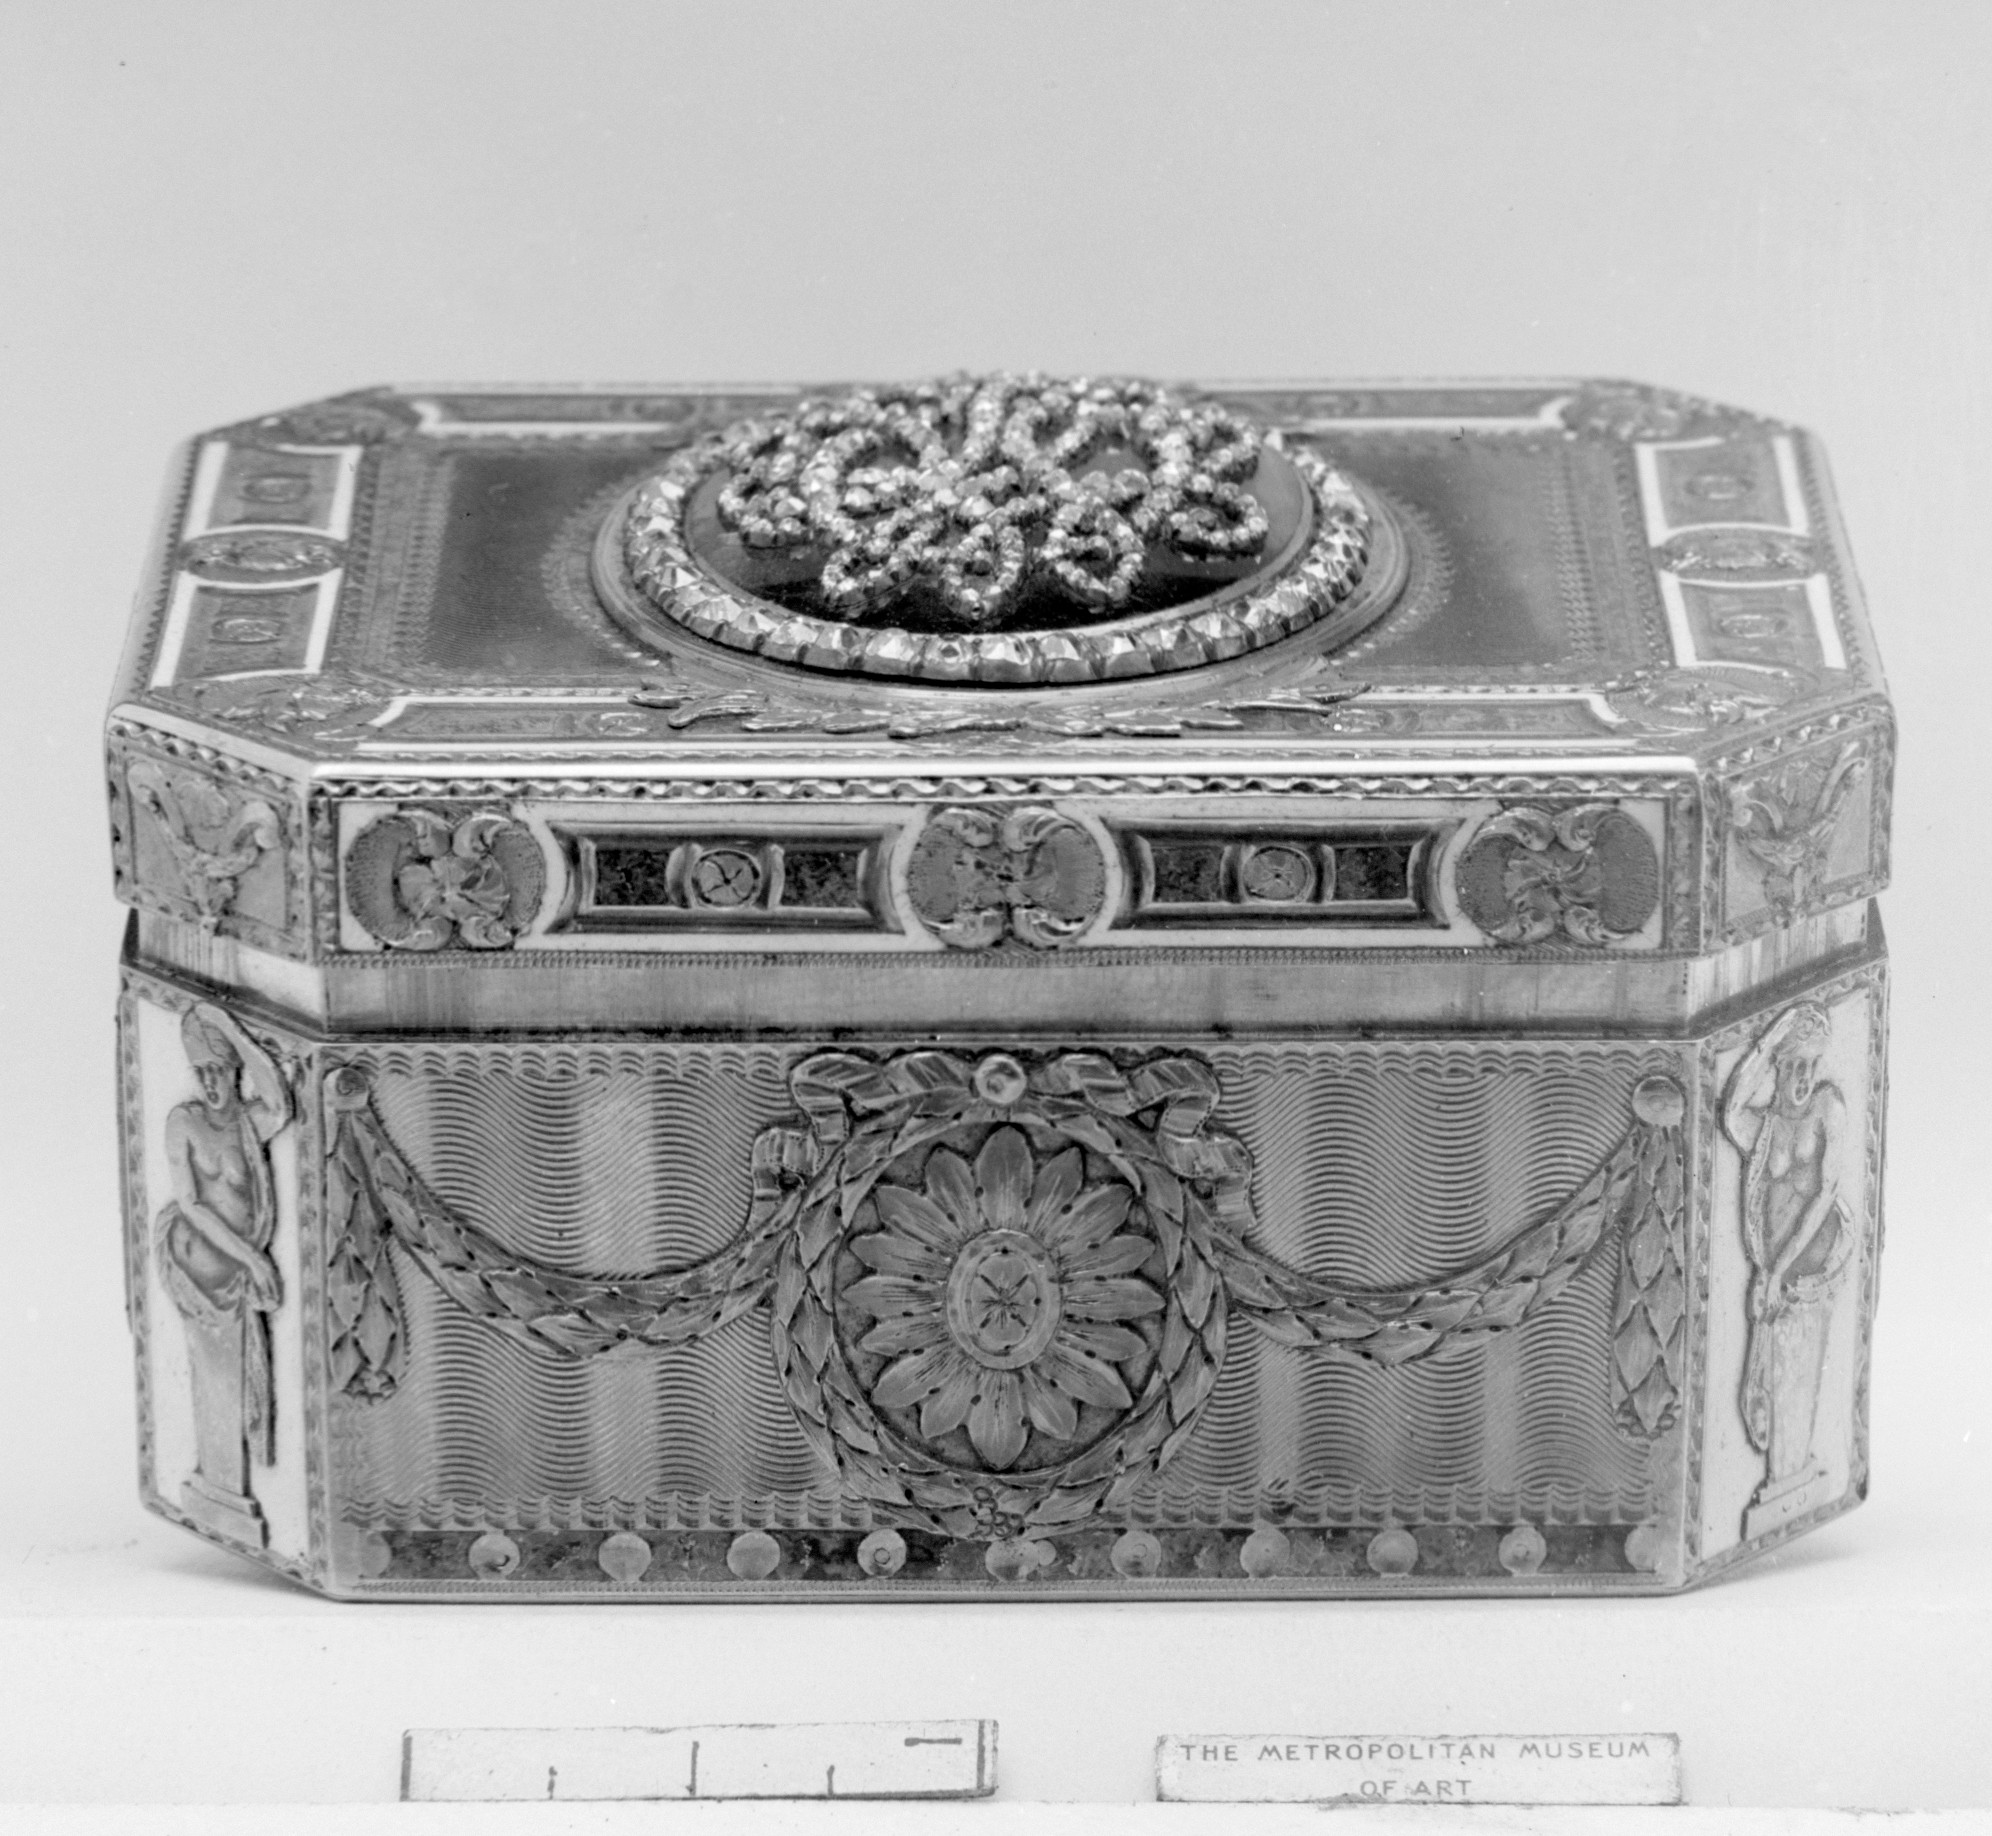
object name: snuffbox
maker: charles le bastier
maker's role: maker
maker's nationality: french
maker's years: 1724-1783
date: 1768-1769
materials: diamond, enamel, gold